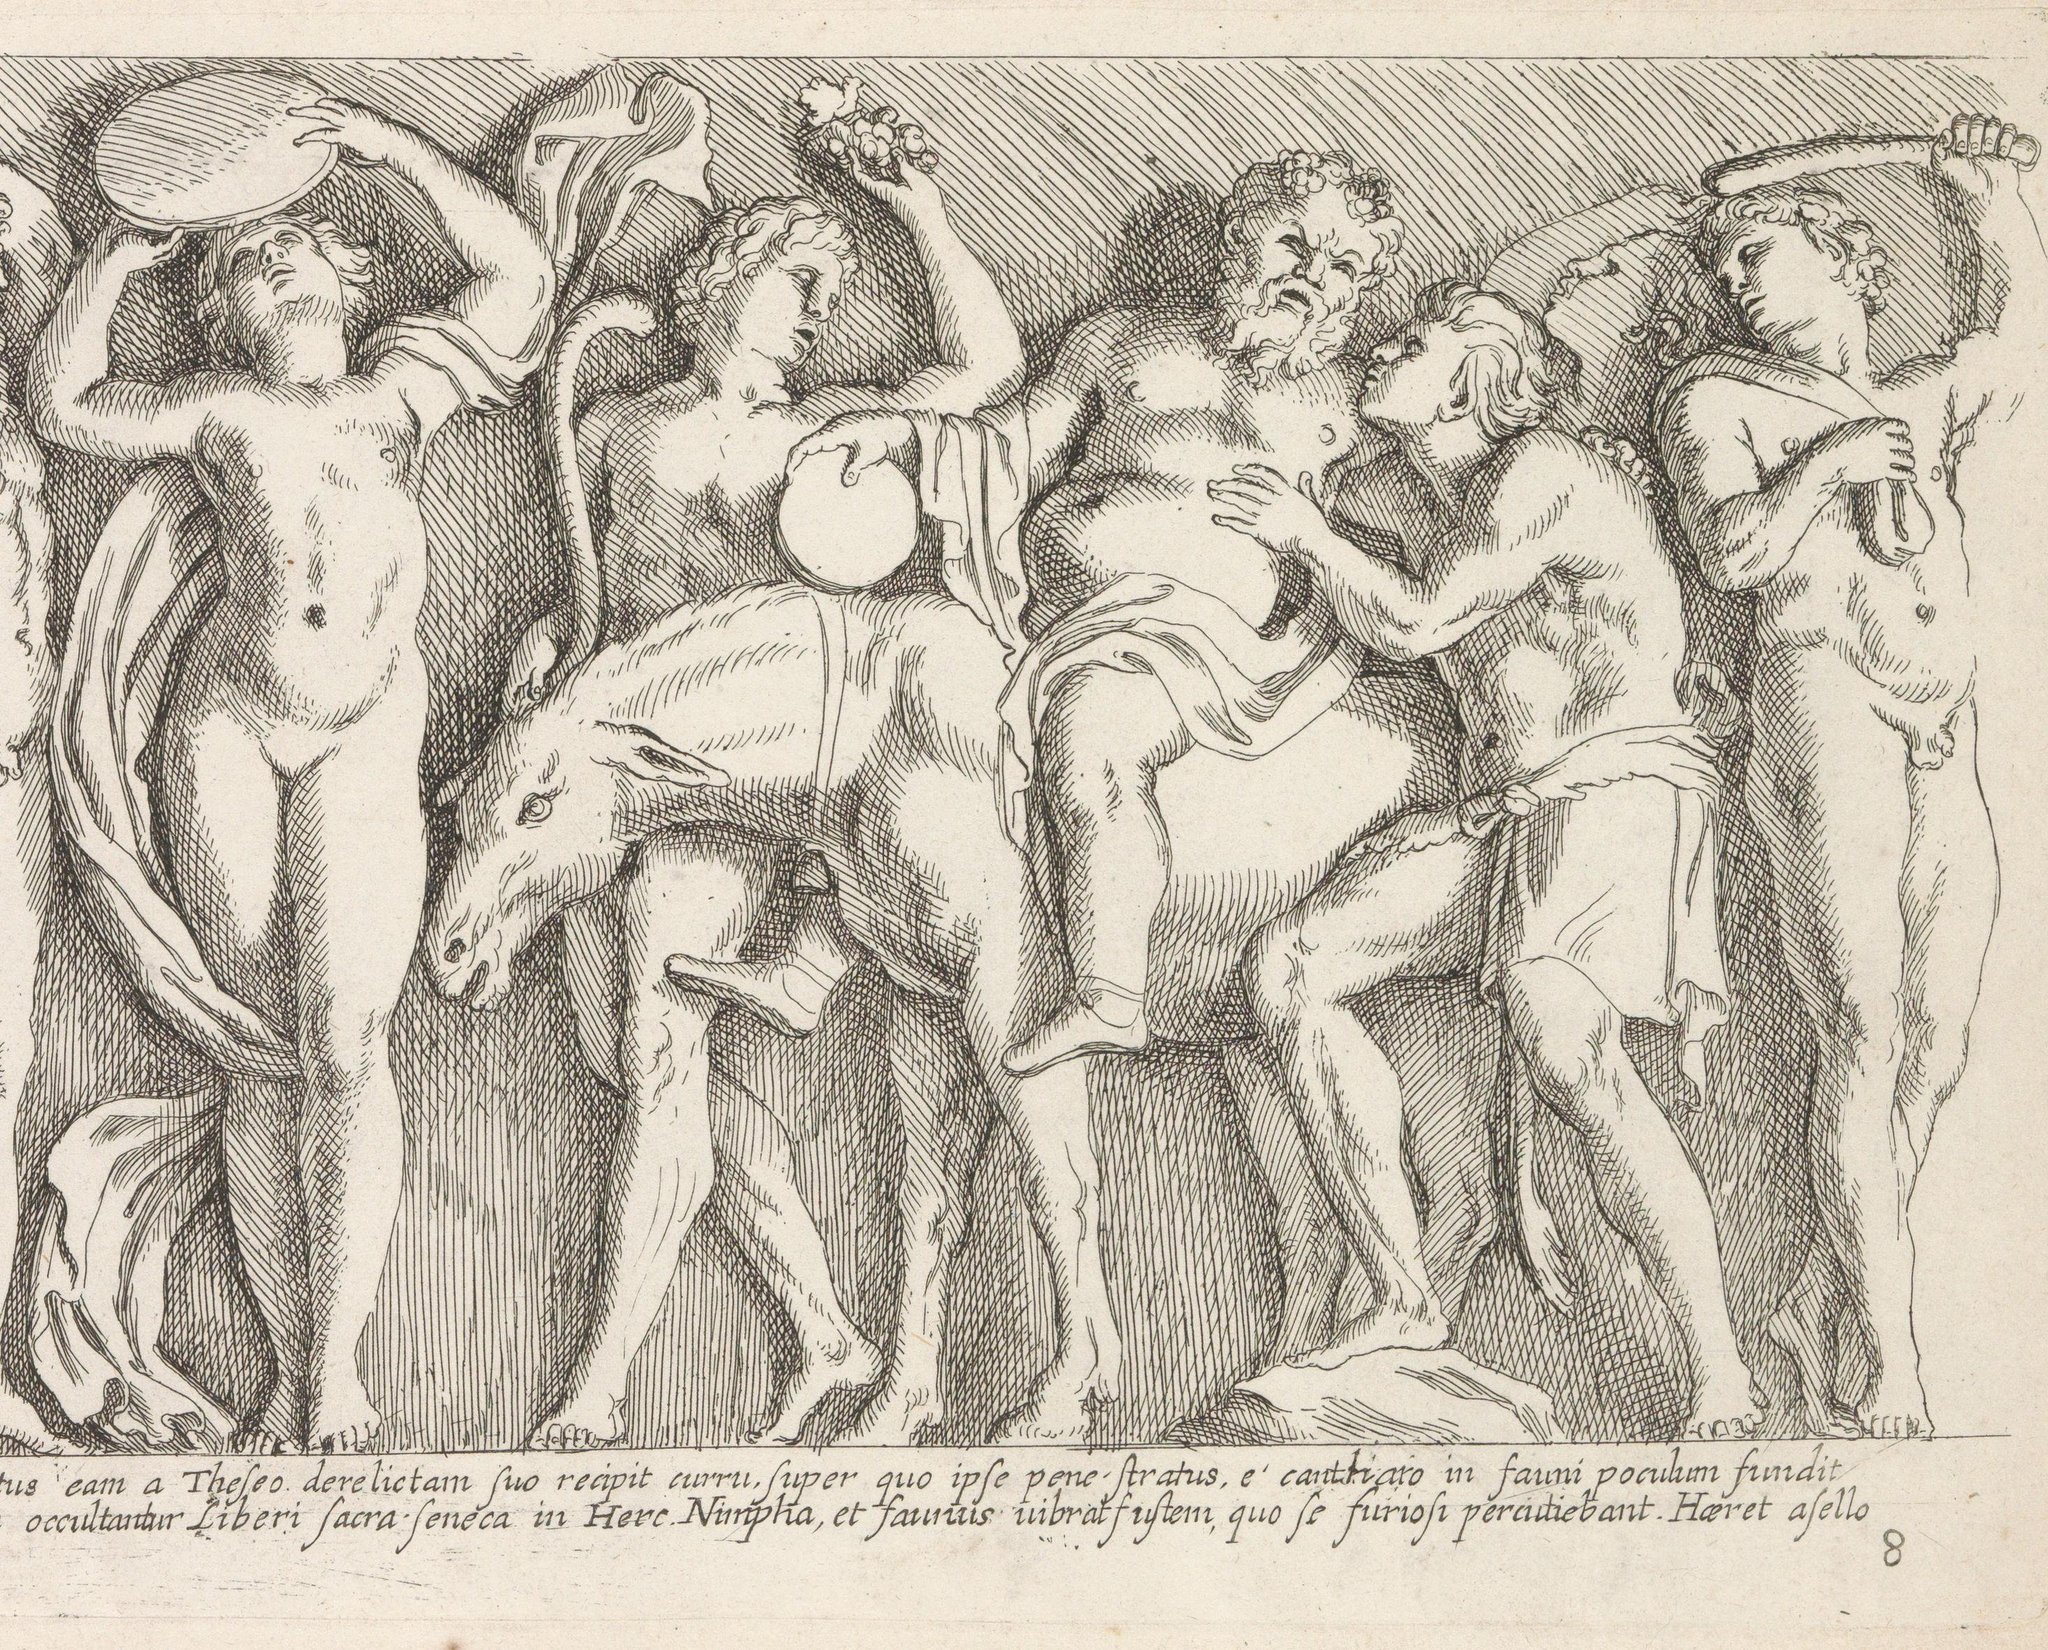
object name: album leaf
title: Reliëf met triomf van Bacchus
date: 1645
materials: paper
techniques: etching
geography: vatican city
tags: triumph of bacchus; 'carro di bacco' (ripa), (story of) silenus, piece of sculpture, reproduction of a piece of sculpture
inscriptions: inscription: ‘Ende lib. No. 5. fol. 121.’, number: ‘35’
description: Deze prent maakt deel uit van een reeks van 54 prenten (+ titelprent) naar antieke reliëfs. De nummering op de prenten loopt van 1 tot en met 50. Sommige prenten hebben dubbele nummers.